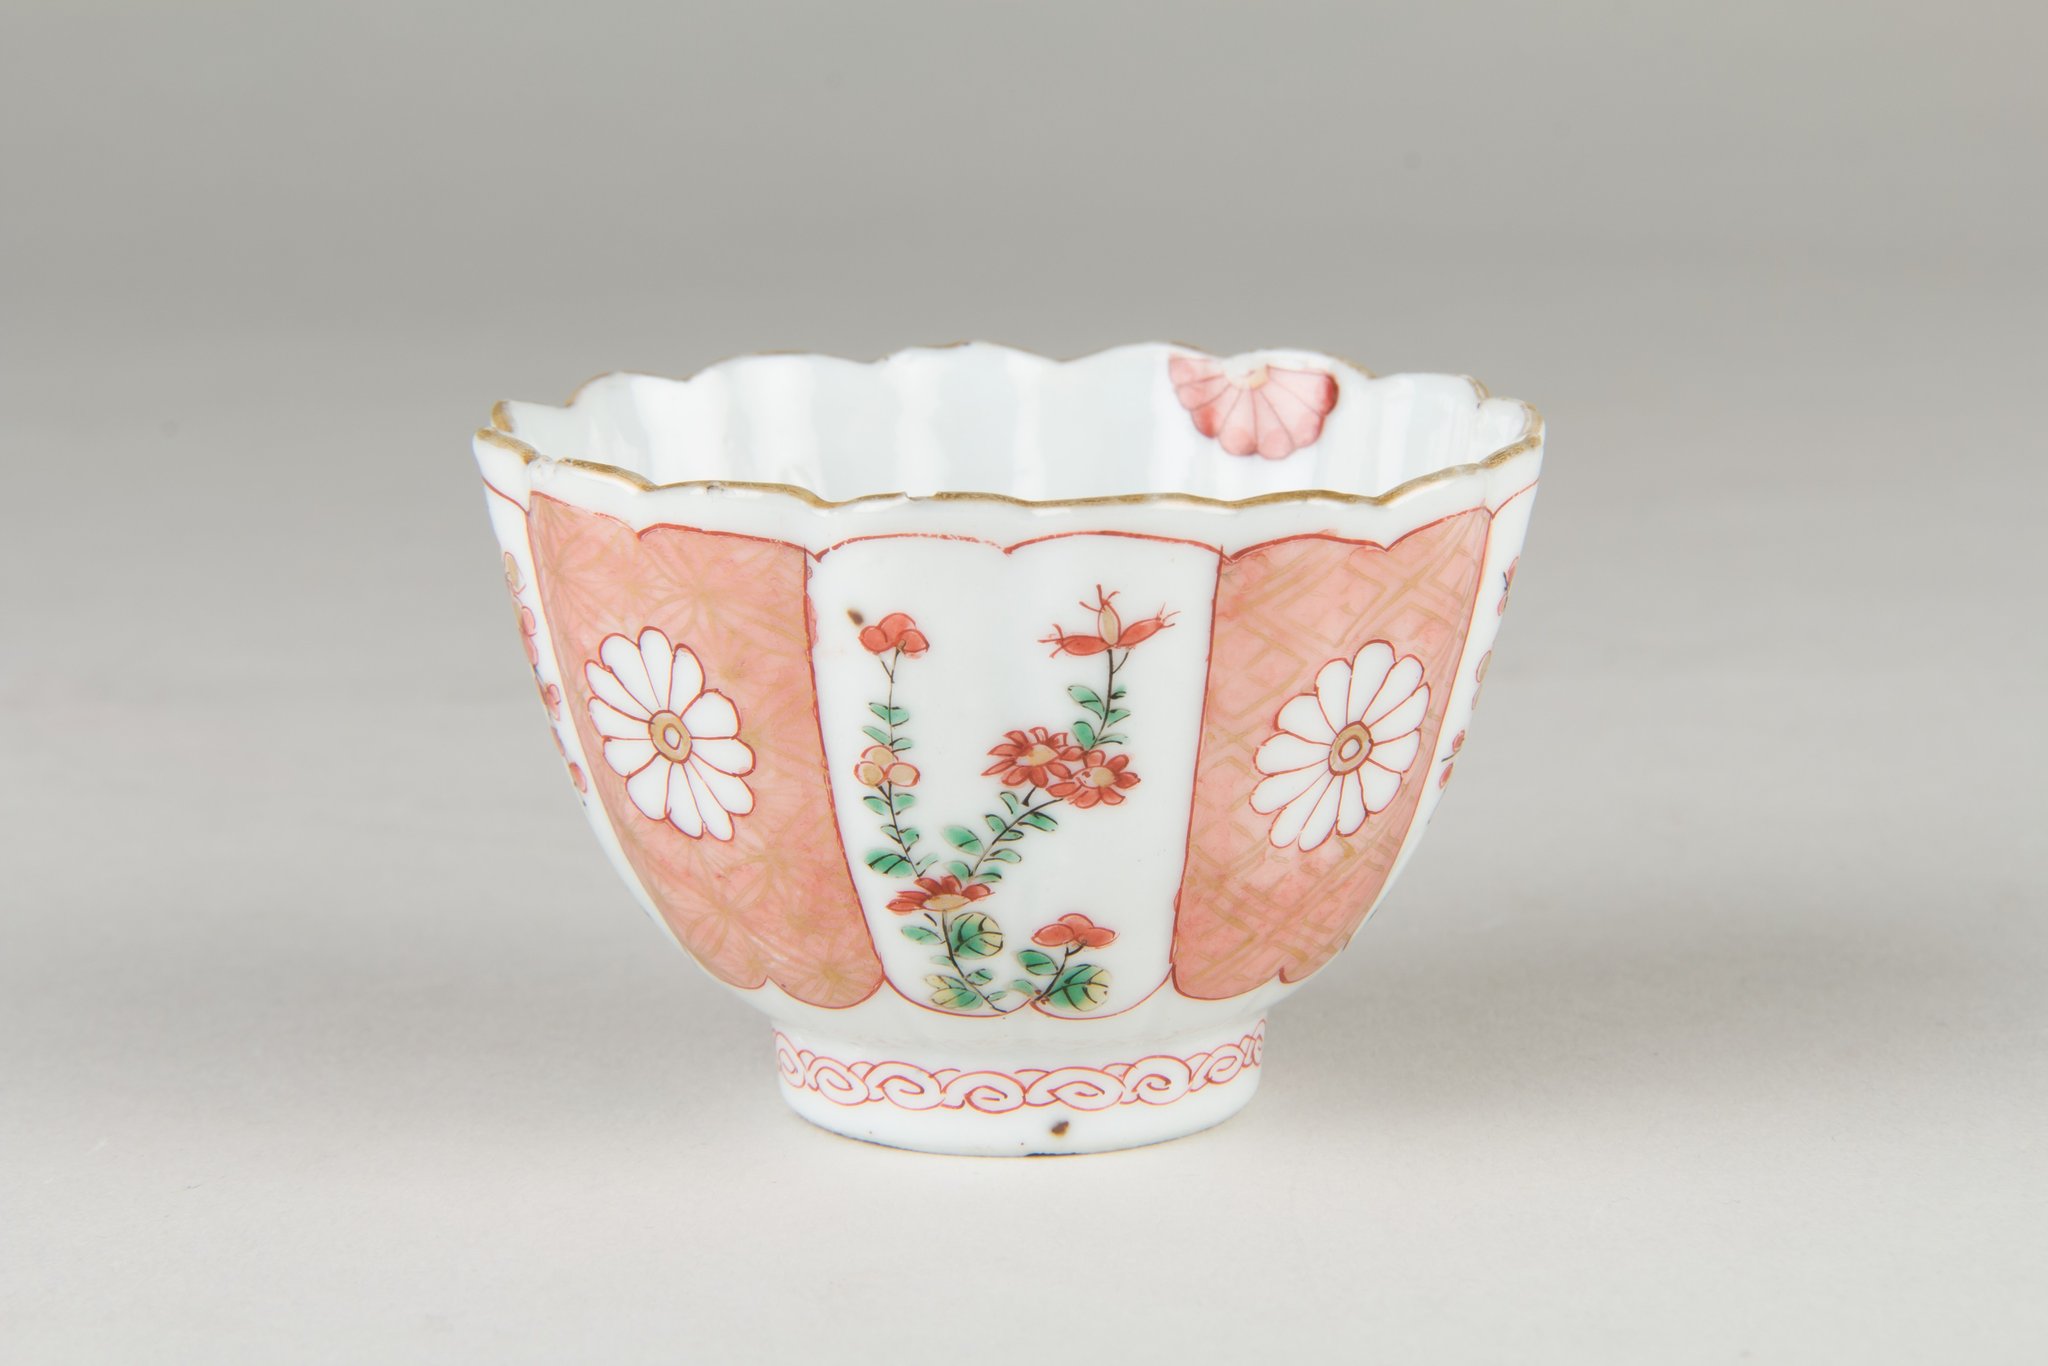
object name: cup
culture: chinese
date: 1701-1733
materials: enamel, gilt, porcelain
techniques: overglaze, painting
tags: flowers